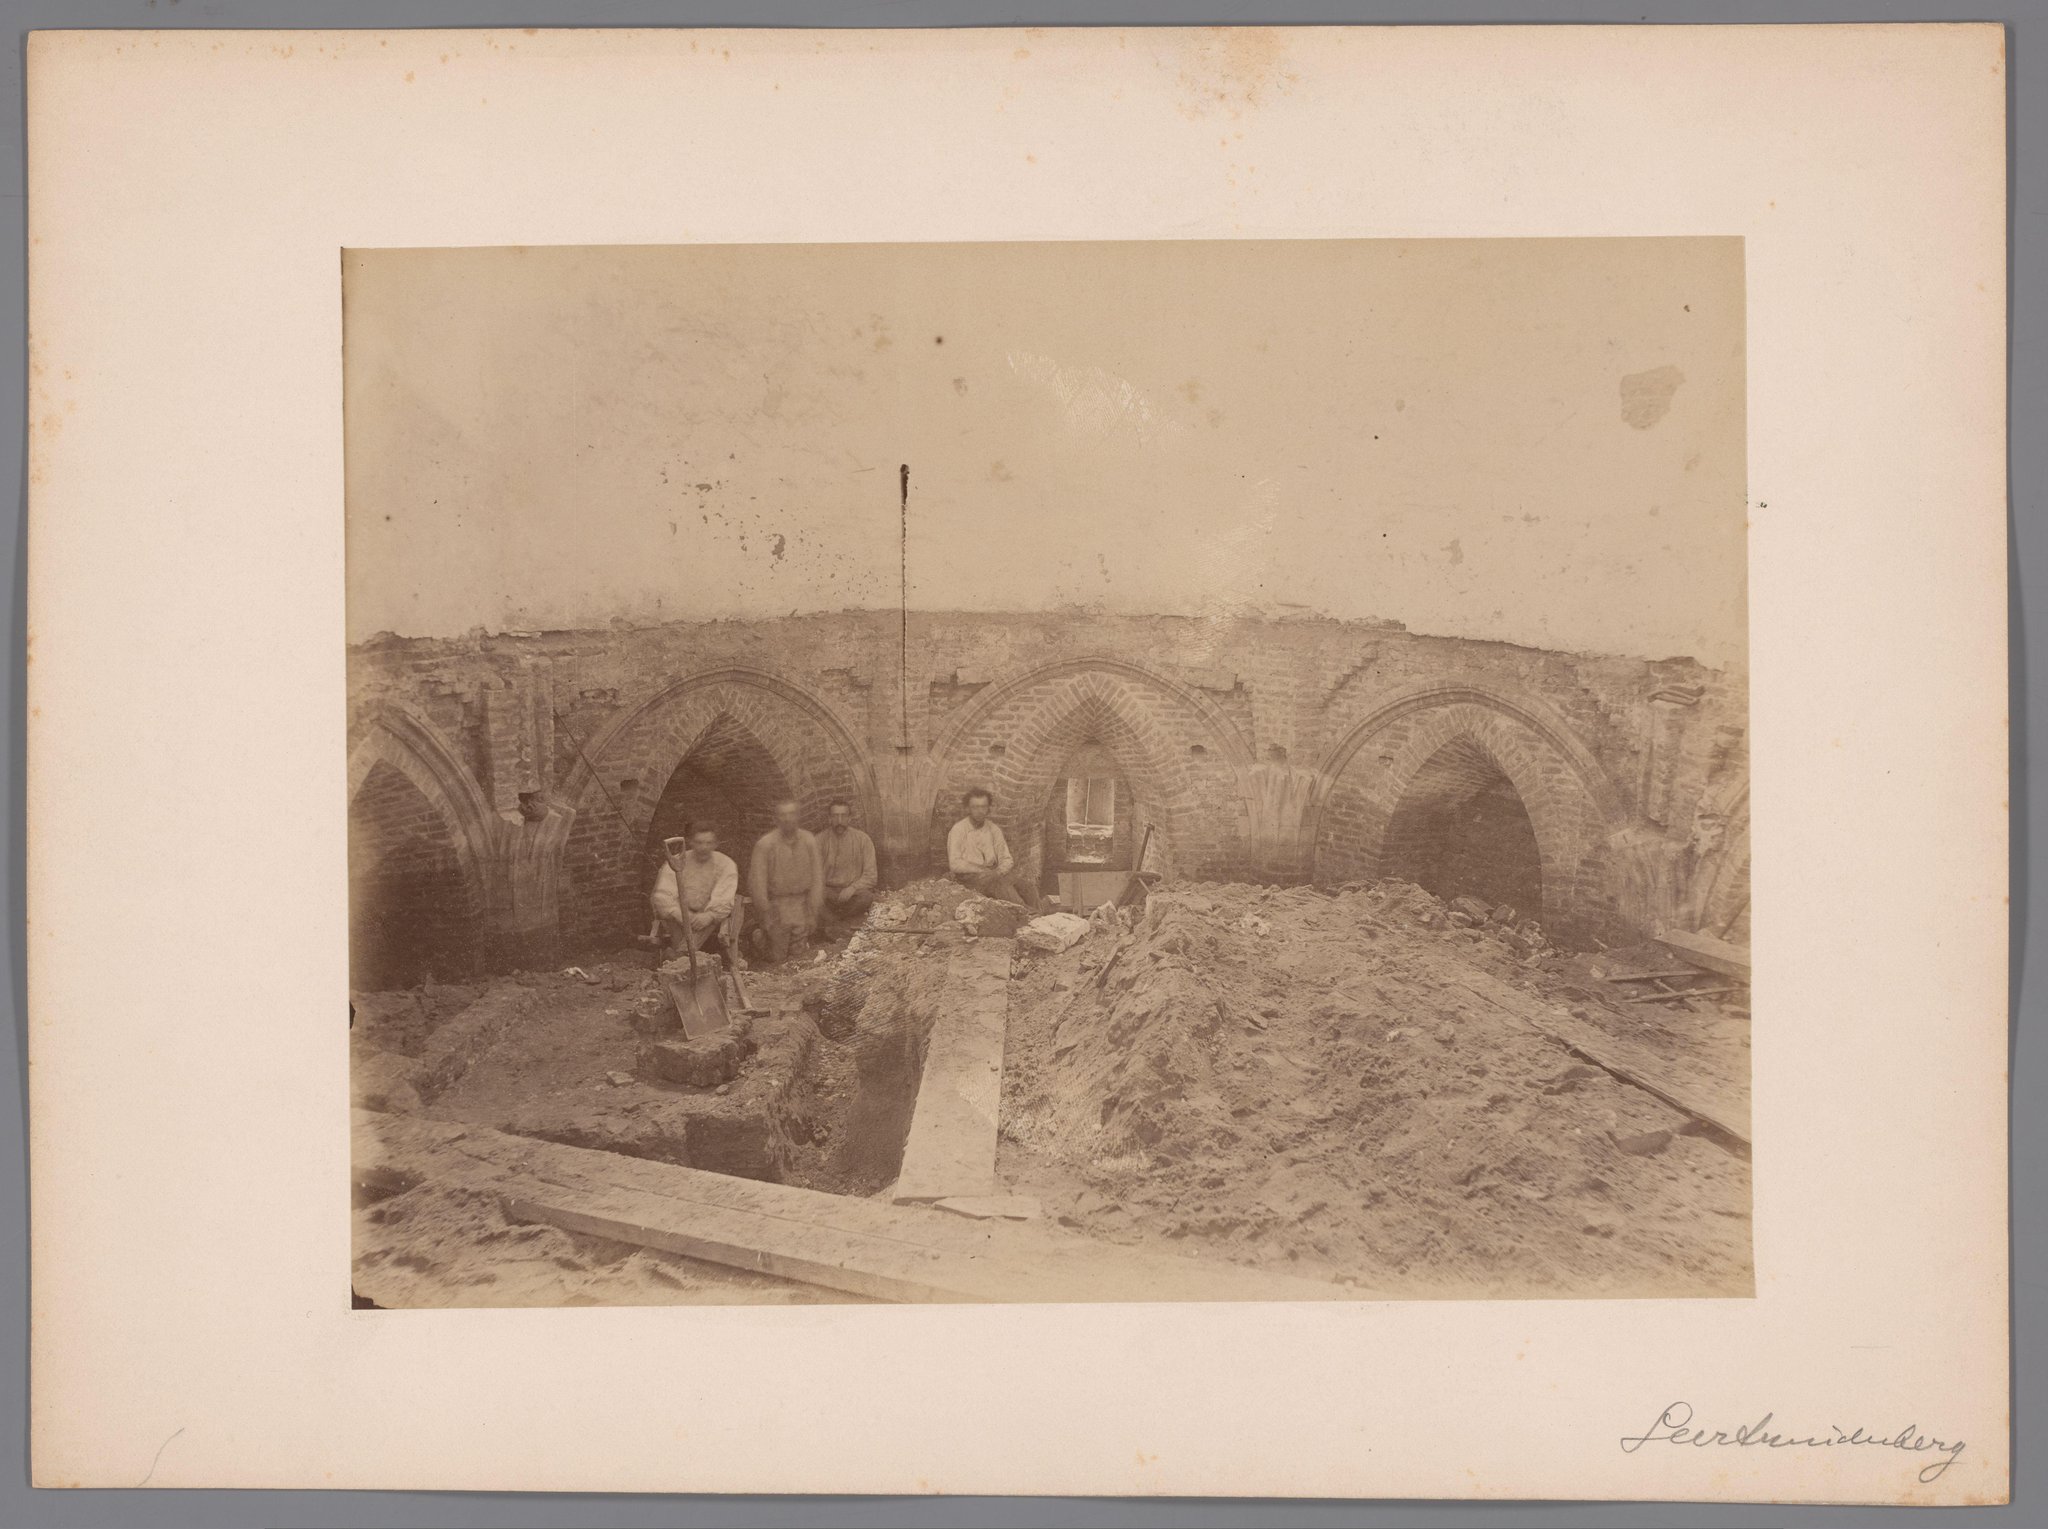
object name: photograph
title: Interieur van een ontgraven crypte in de Geertruidskerk te Geertruidenberg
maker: anoniem (monumentenzorg)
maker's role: fotograaf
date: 1895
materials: cardboard, photographic support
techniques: albumen print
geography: geertruidenberg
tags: parts of church interior (crypt), geertruidenberg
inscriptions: annotation: ‘Geertuidenberg (N.B.)/ N.H. Kerk/ Korcht in het koor 5 dagen na het begin der ontgraving/ sept 1895’, annotation: ‘Geertruidenberg’